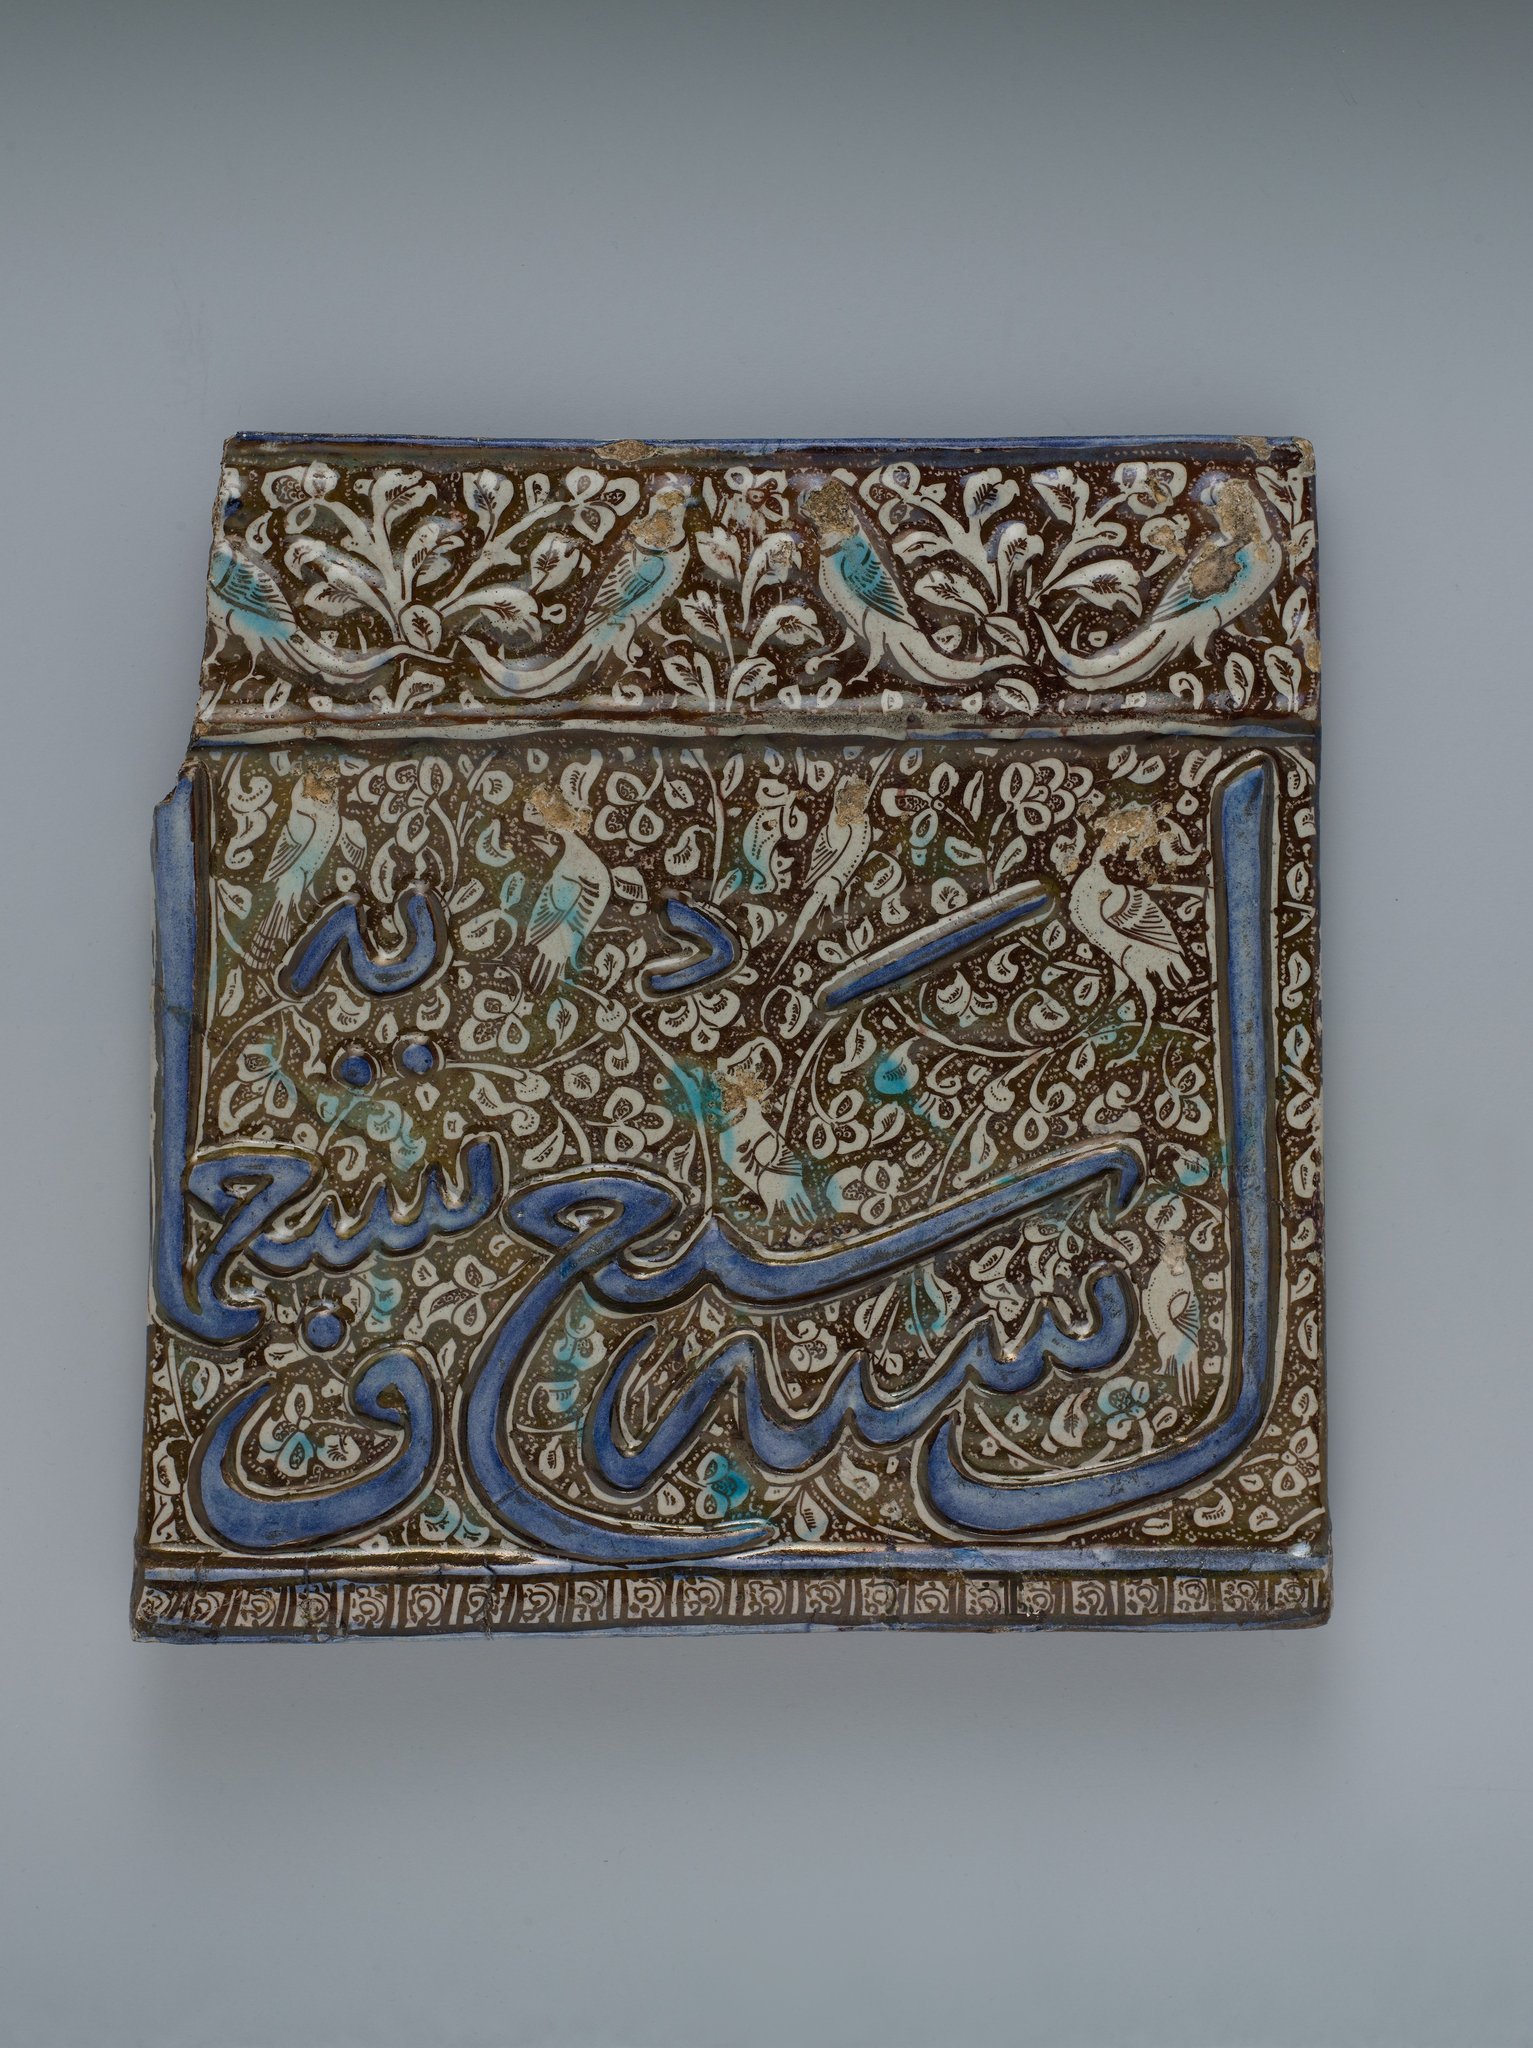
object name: tile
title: Tile From an Inscriptional Frieze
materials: stonepaste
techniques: luster painting, painting, underglaze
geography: iran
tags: birds,arabic